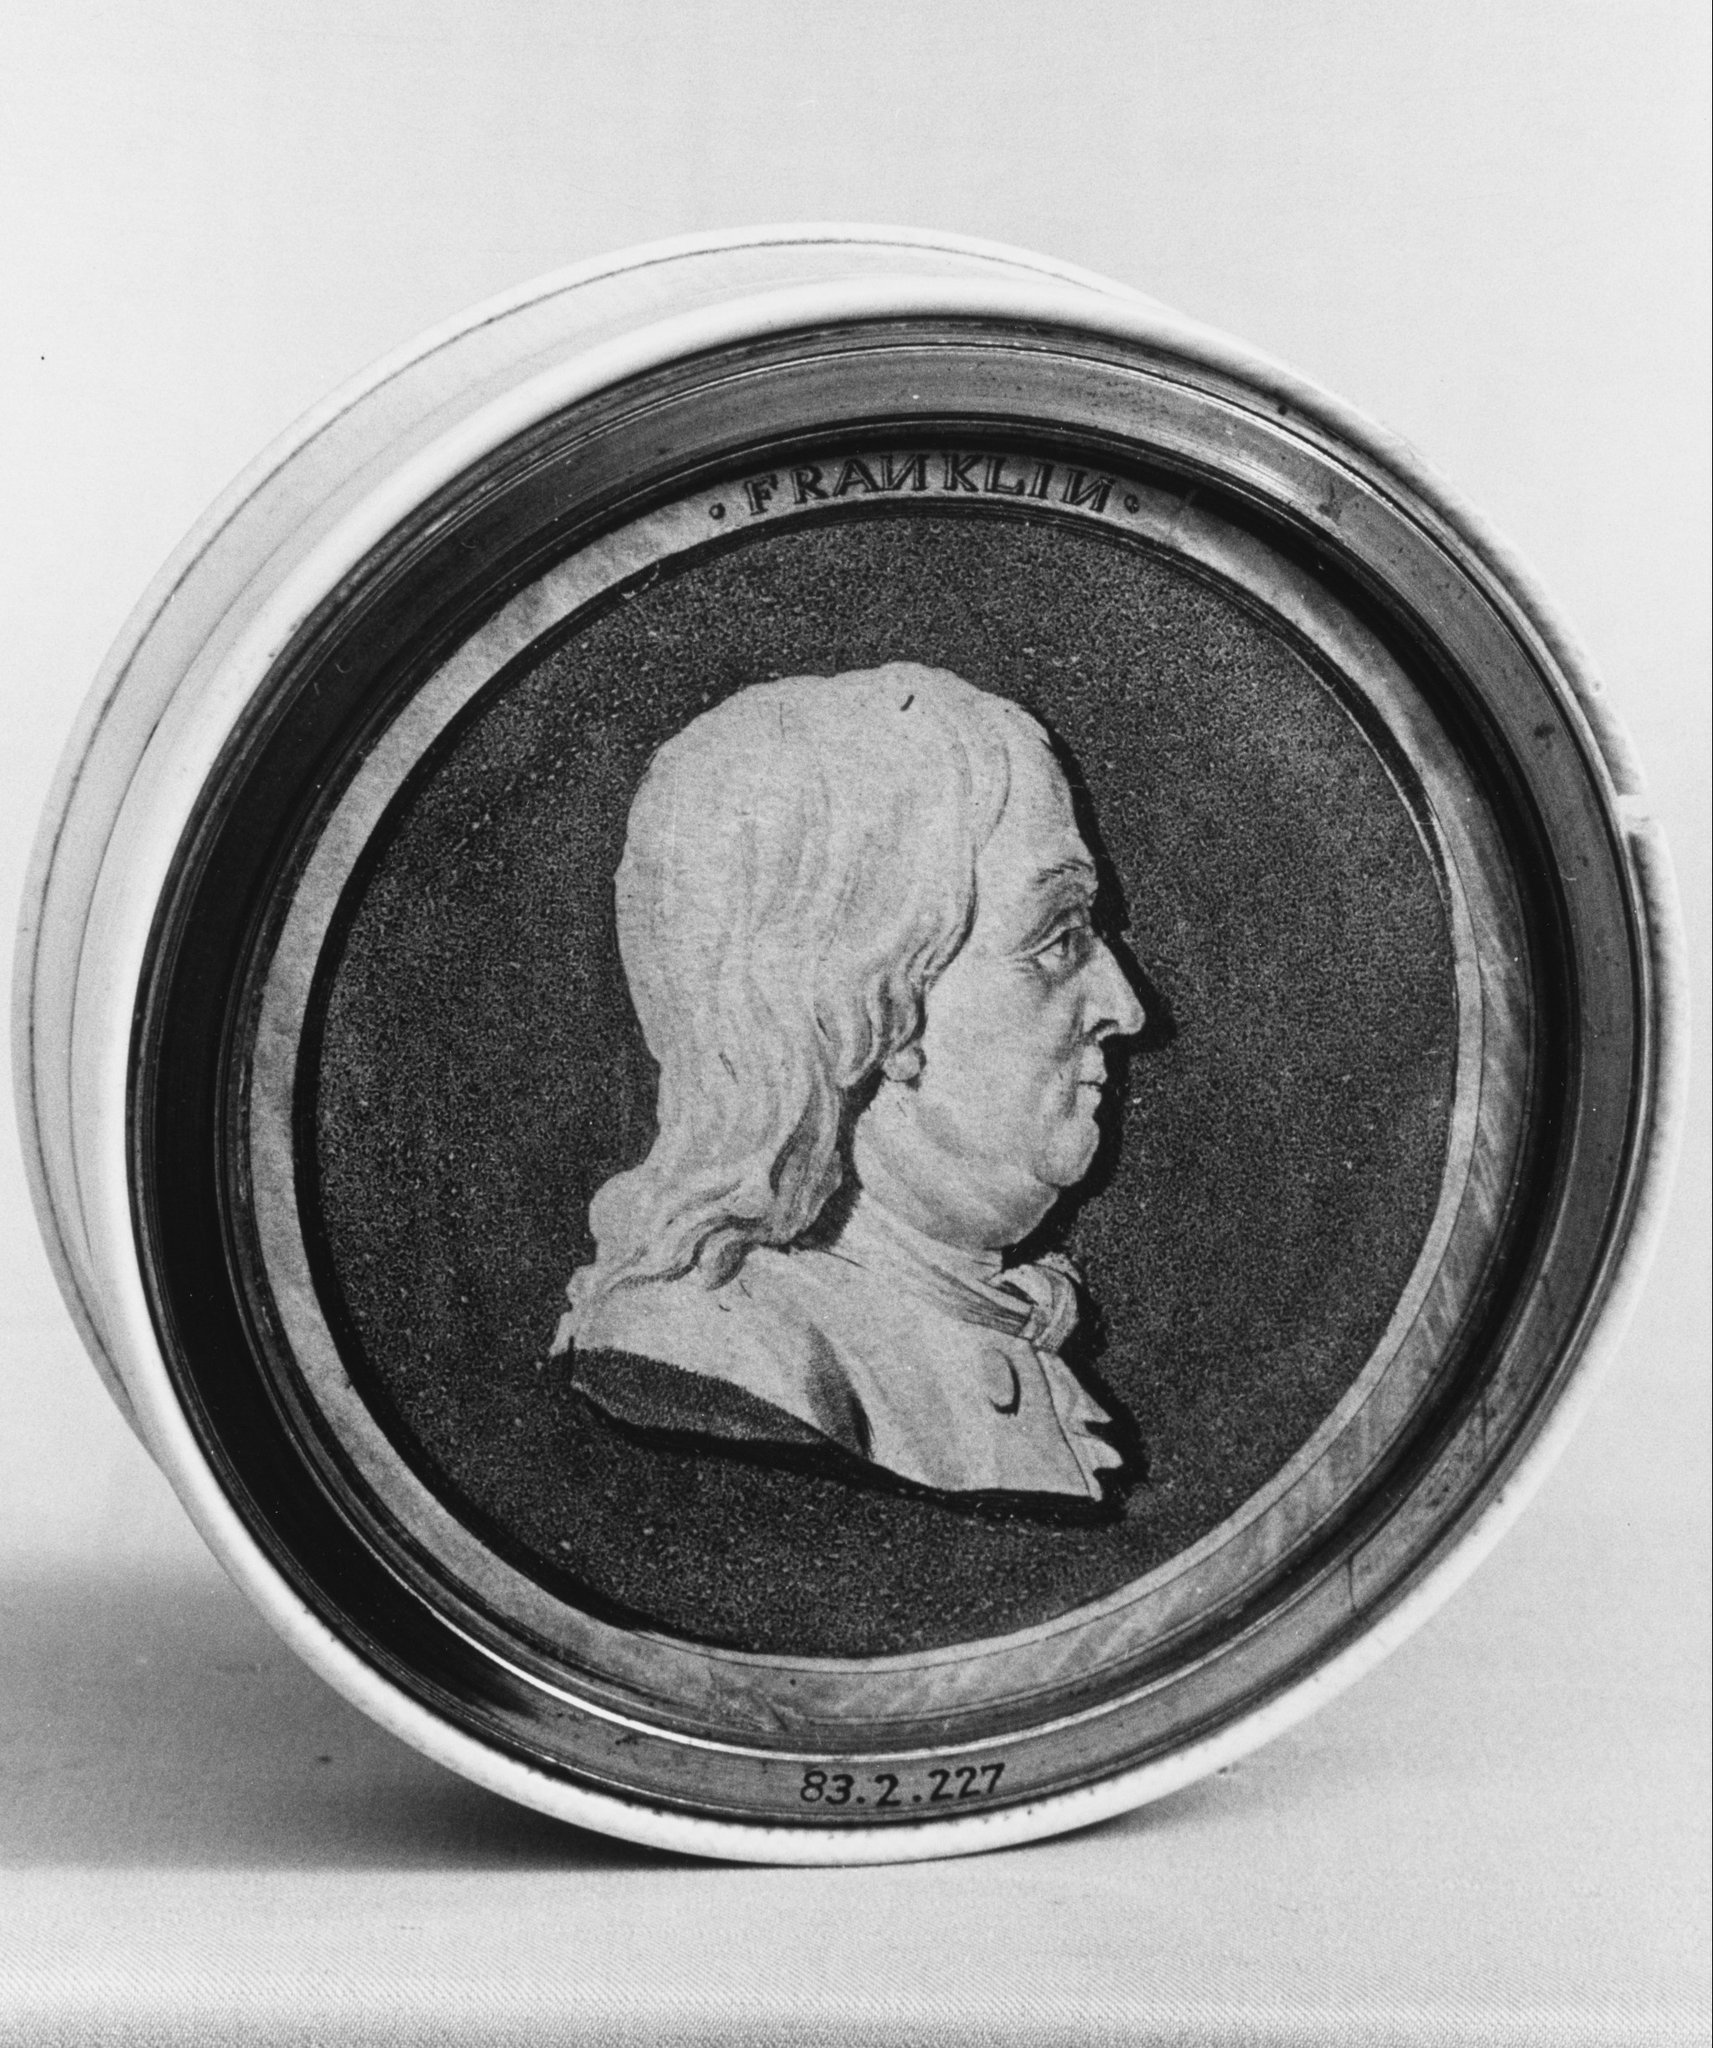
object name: box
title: Box with Medallion Top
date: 1760-1883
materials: ivory, shell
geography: france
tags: benjamin franklin,profiles